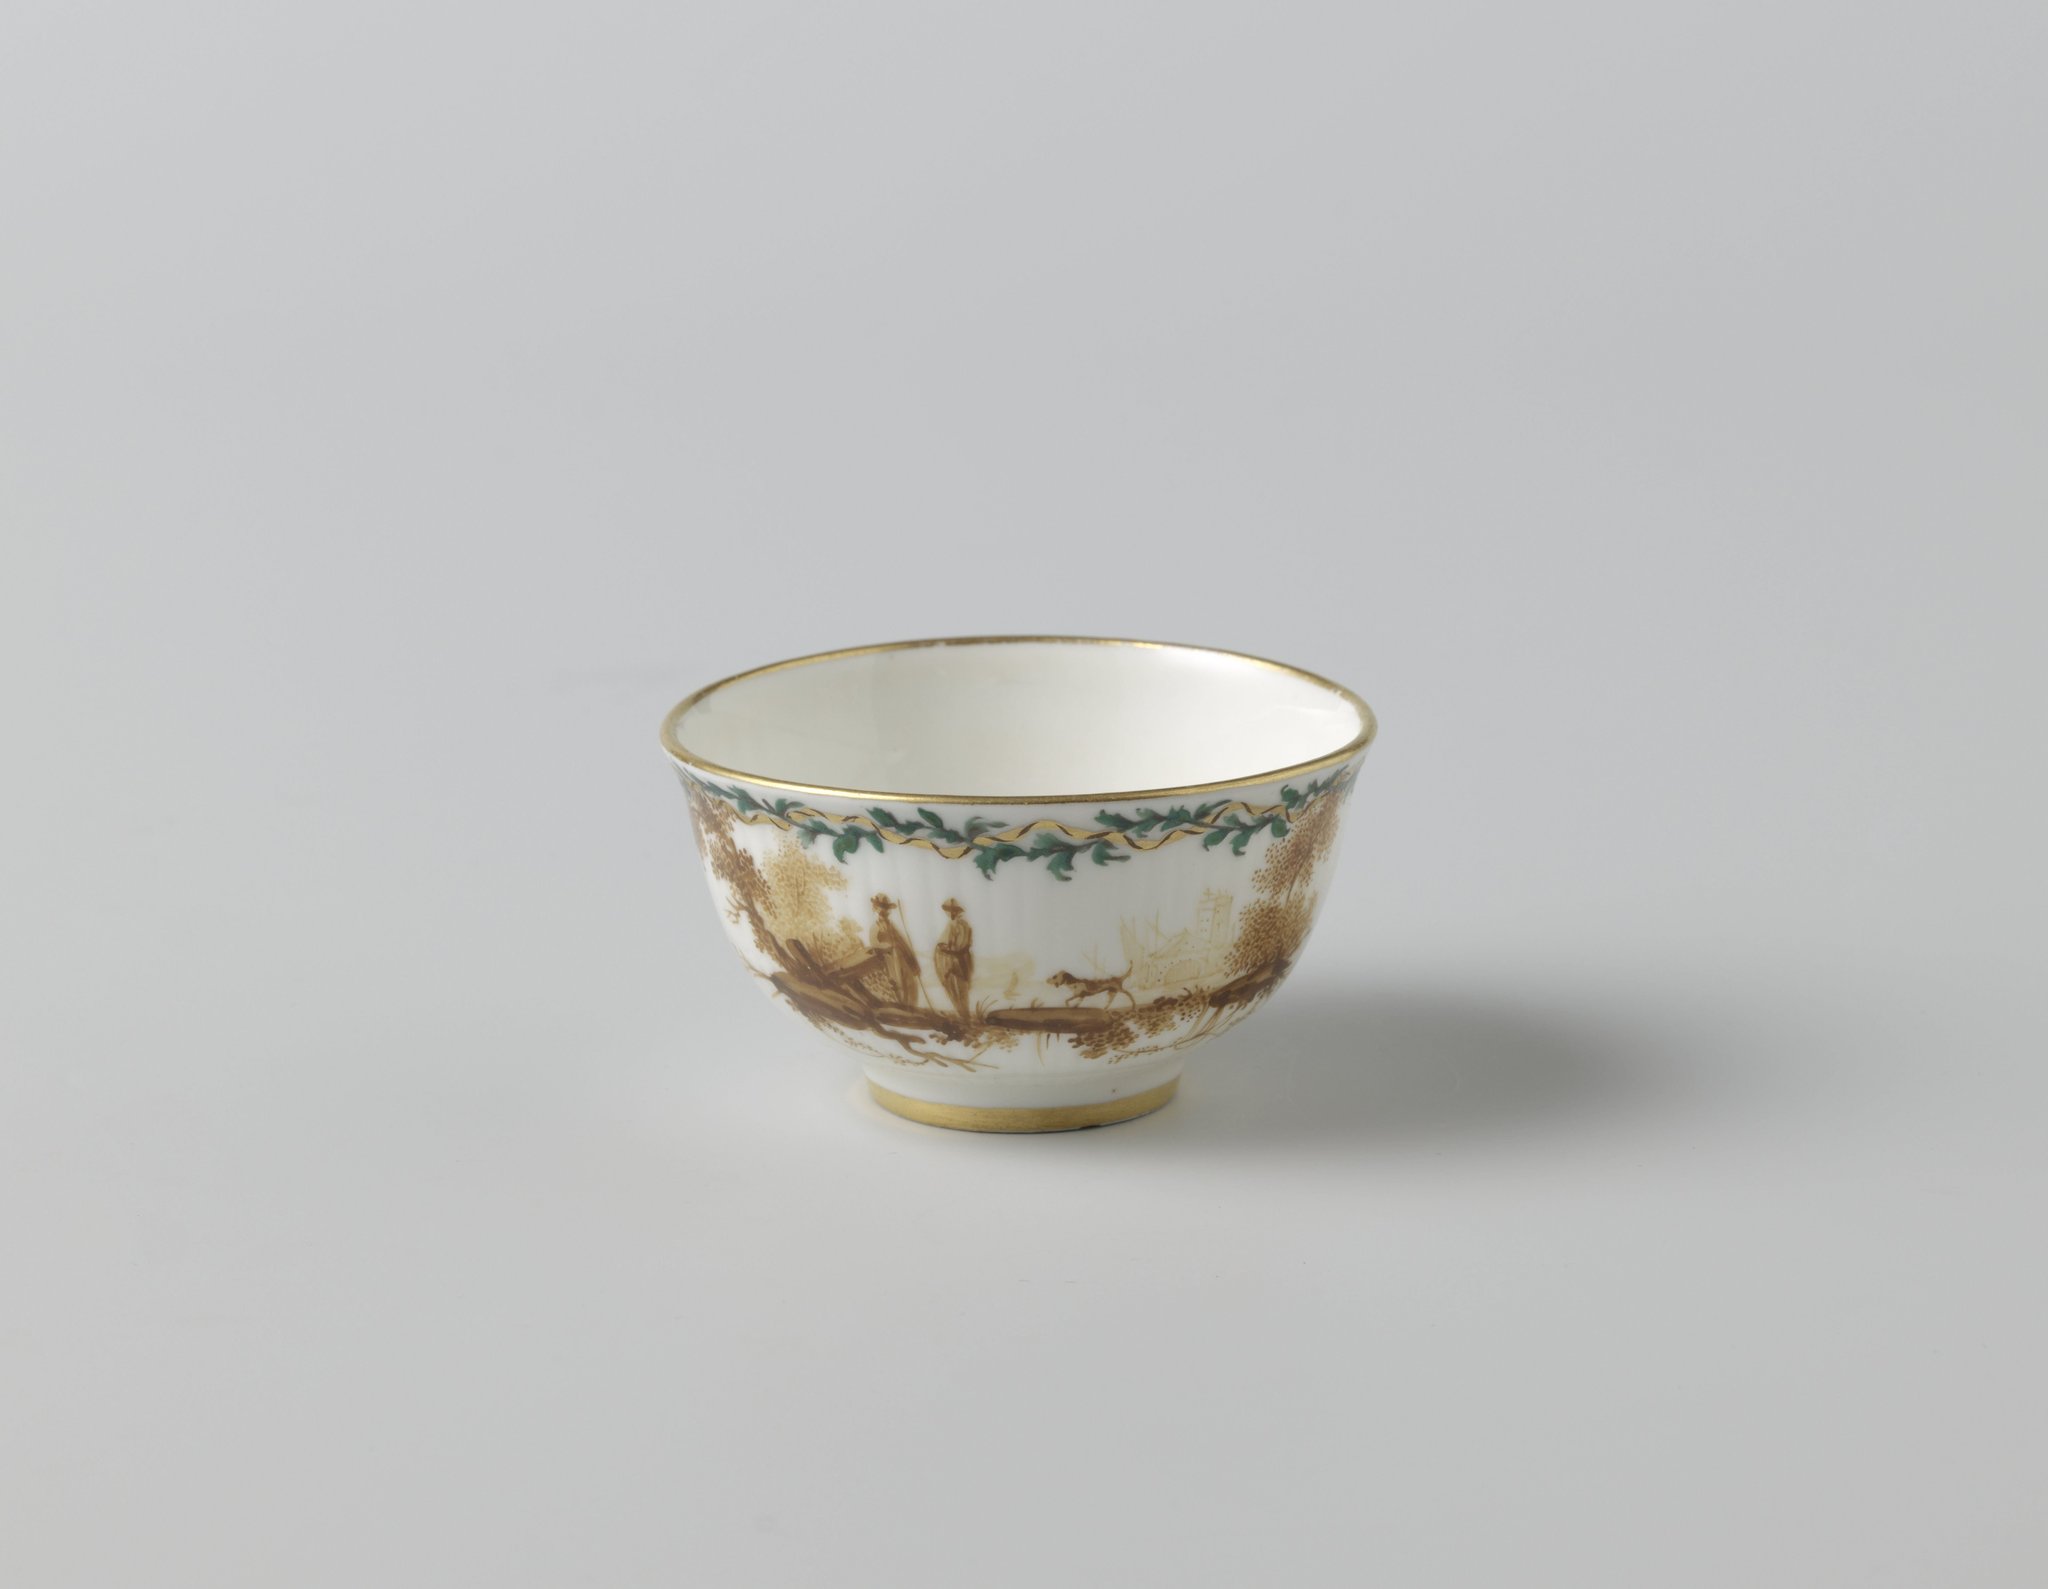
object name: kop en schotel, kop en schotel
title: Kop-en-schotel, beschilderd met figuren in landschappen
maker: fidelle duvivier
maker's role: porseleinschilder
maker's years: 1740-1817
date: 1778-1782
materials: porcelain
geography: loosdrecht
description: Tea cup and saucer. Porcelain. Loosdrecht, c. 1778 - 1782. Factory of Joannes de Mol.